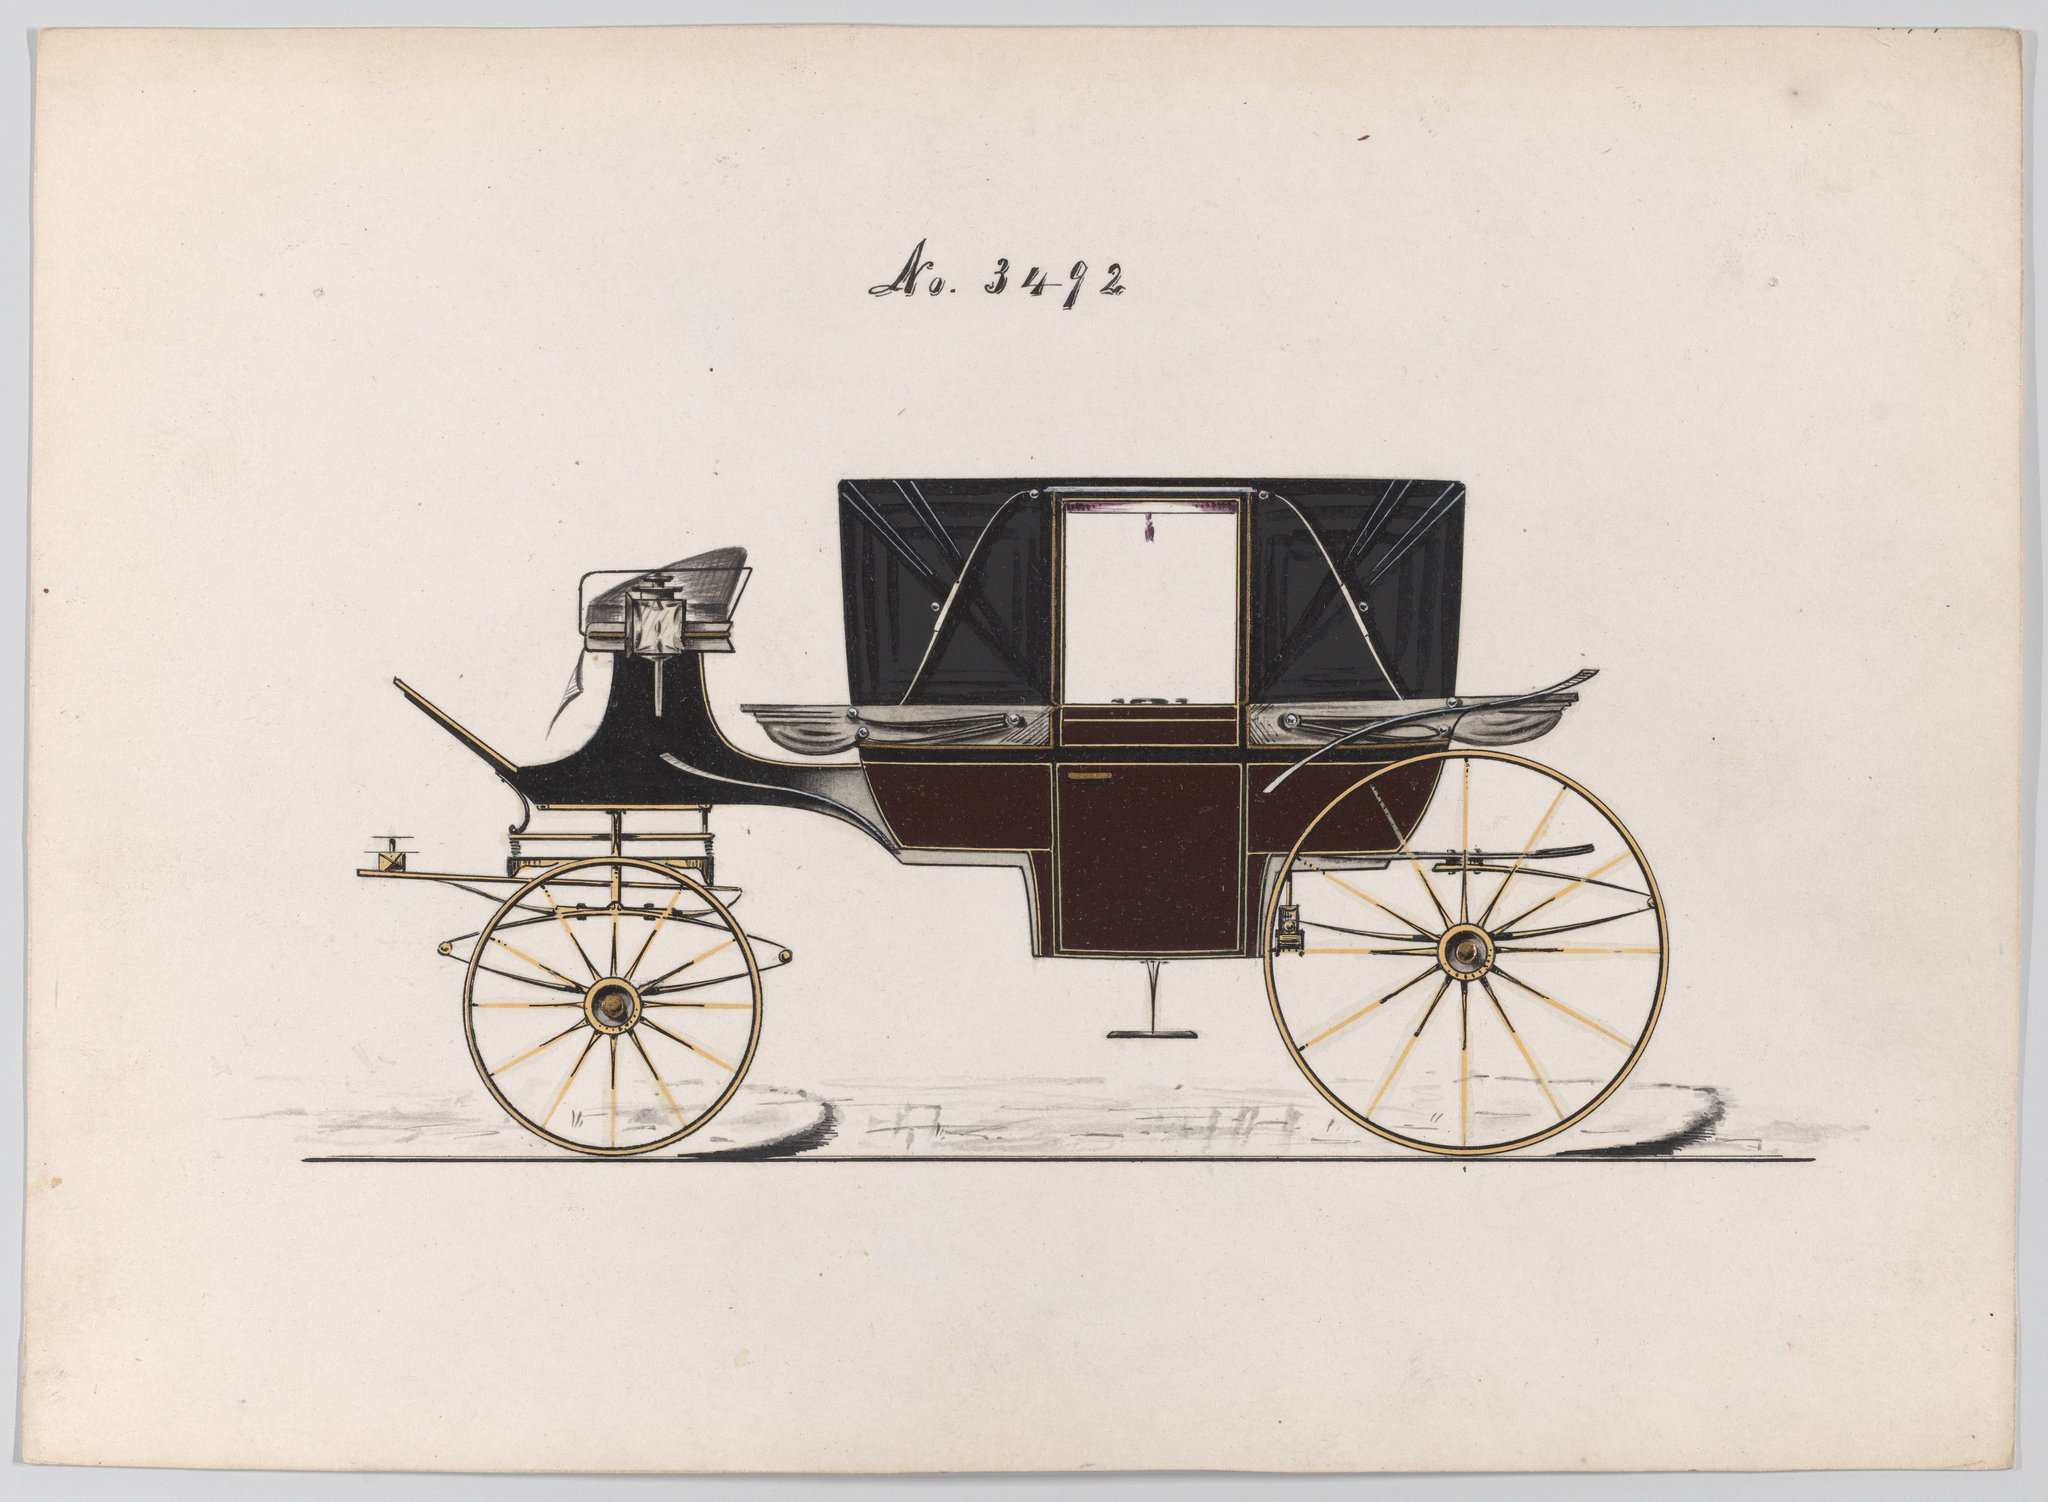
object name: drawing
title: Design for Landau, No. 3492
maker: brewster & co.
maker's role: manufacturer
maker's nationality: american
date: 1879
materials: gouache, gum arabic, ink, watercolor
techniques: pen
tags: carriages